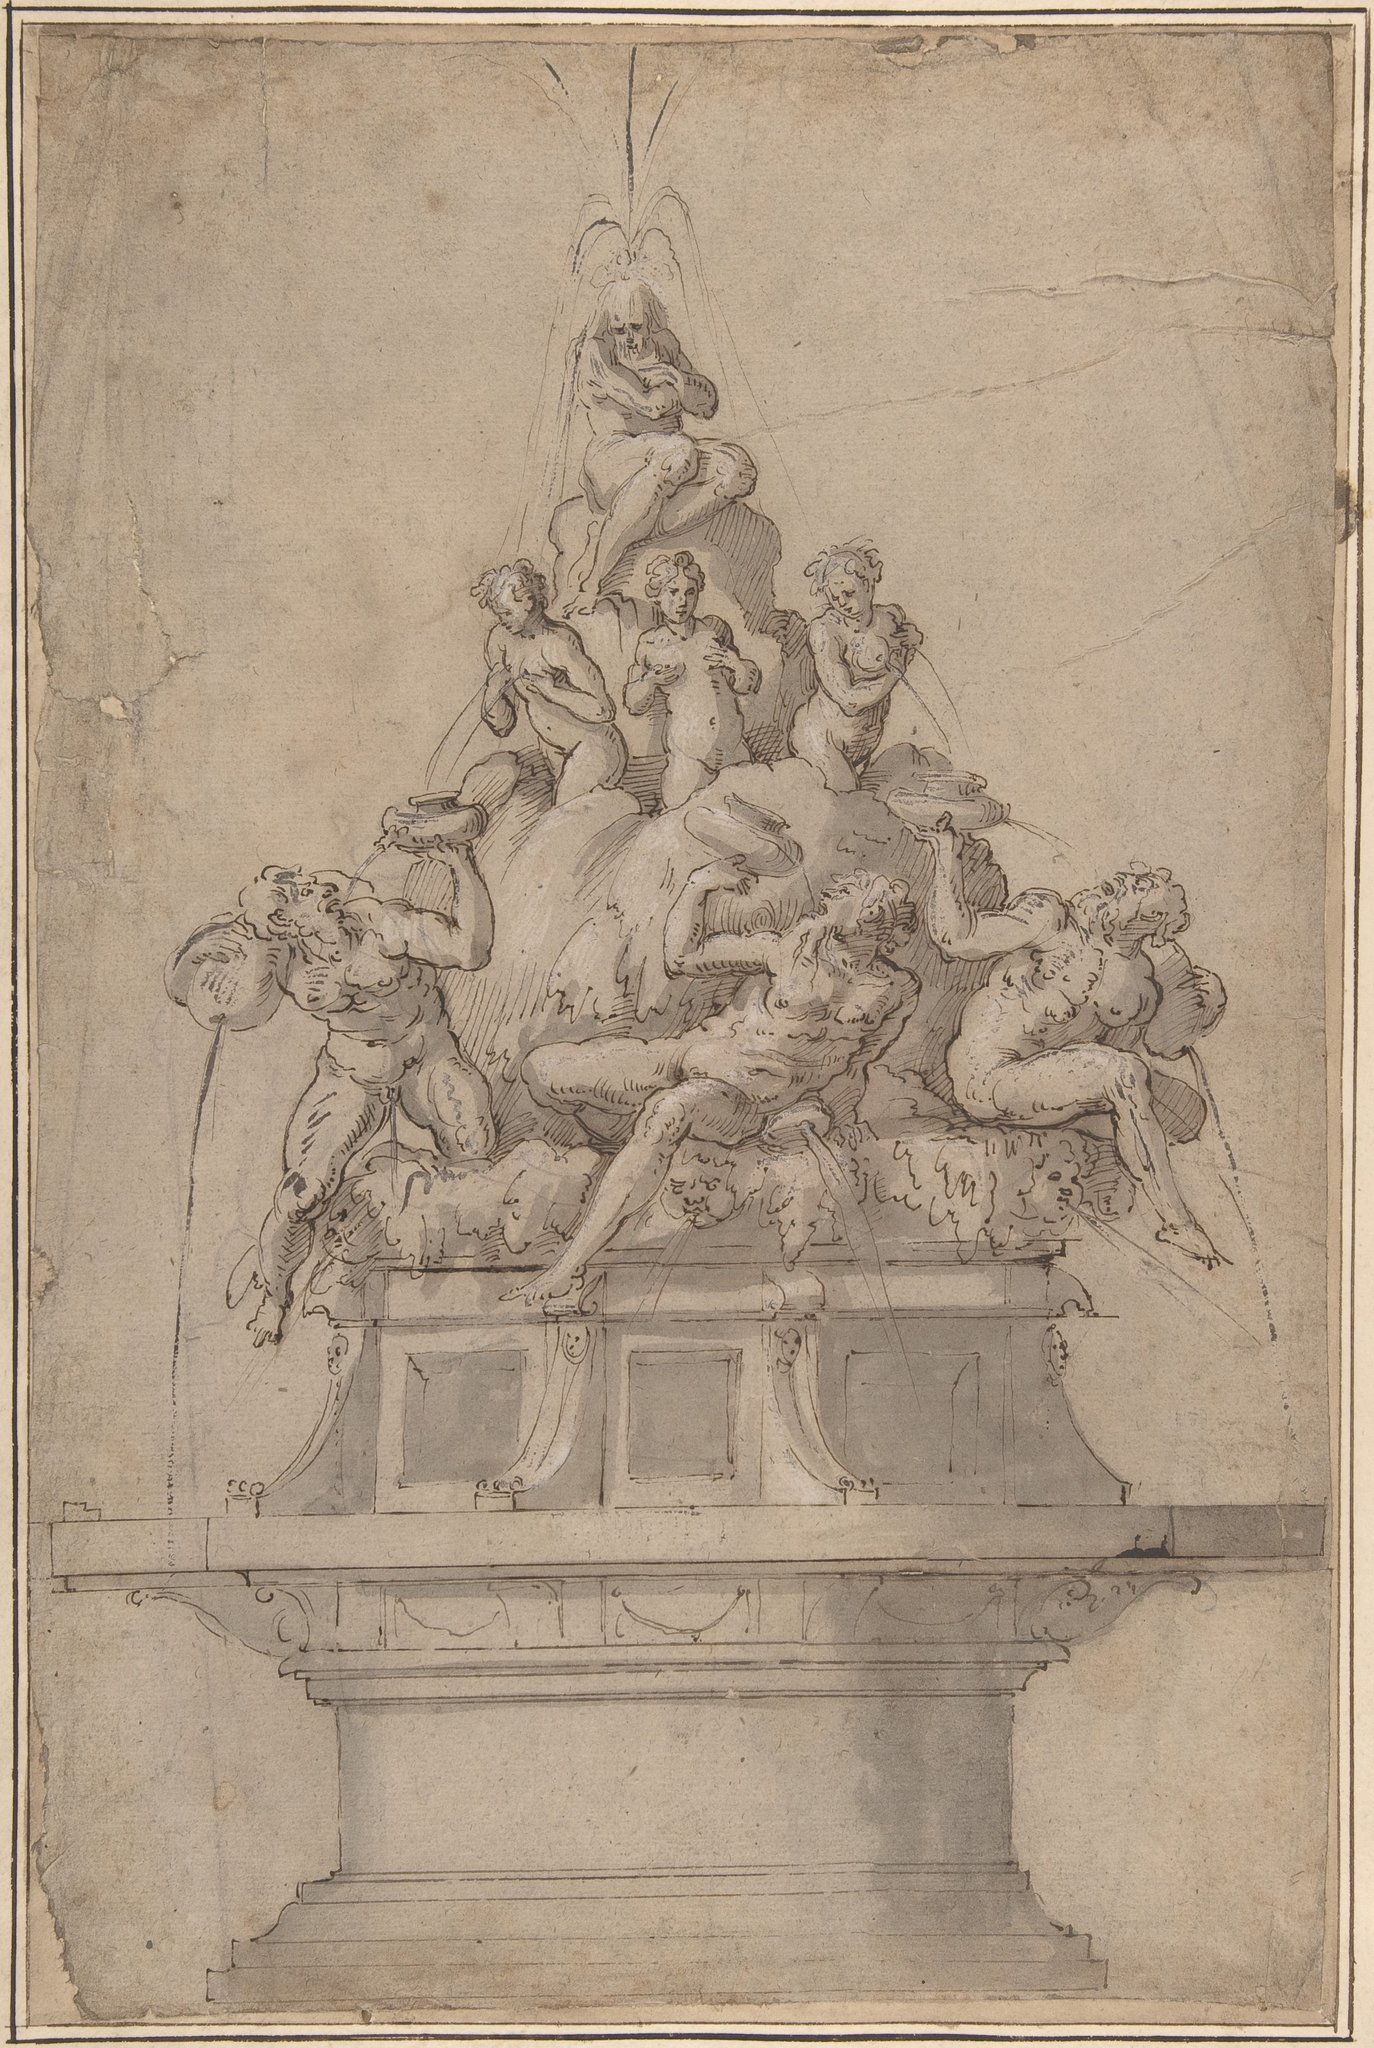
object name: drawing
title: Design for a Fountain with Rivergods and Nymphs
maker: giorgio vasari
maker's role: artist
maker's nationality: italian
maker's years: 1511-1574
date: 1511-1574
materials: gouache, graphite, ink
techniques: brush, highlighting, pen, wash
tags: fountains,male nudes,female nudes,nymphs